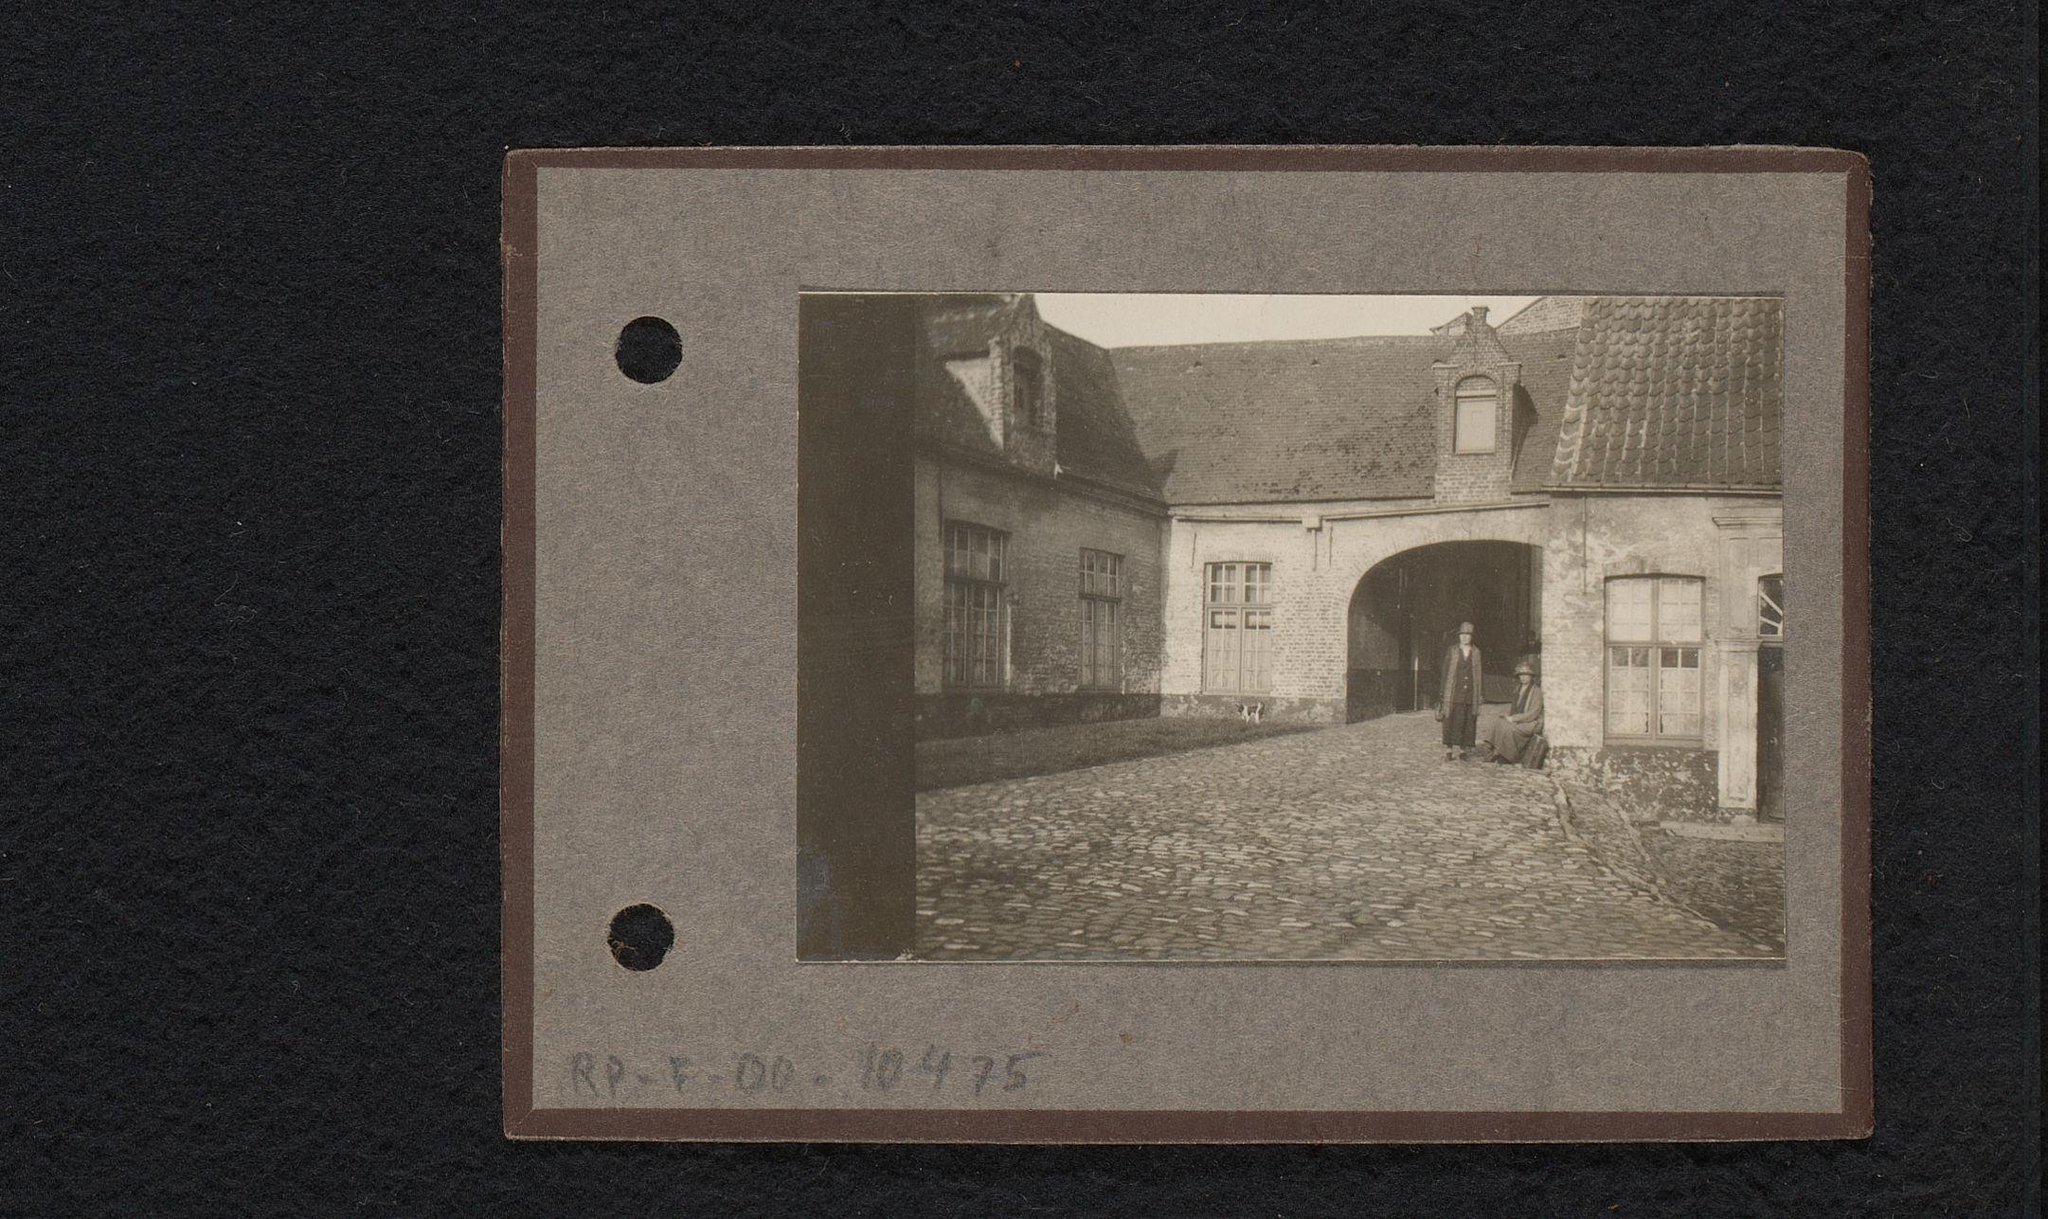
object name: photograph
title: Twee vrouwen op een binnenplaats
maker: Anonymous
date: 1900-1930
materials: paper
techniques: gelatin silver print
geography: netherlands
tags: historical persons not known by name - bb - woman, façade of inner court